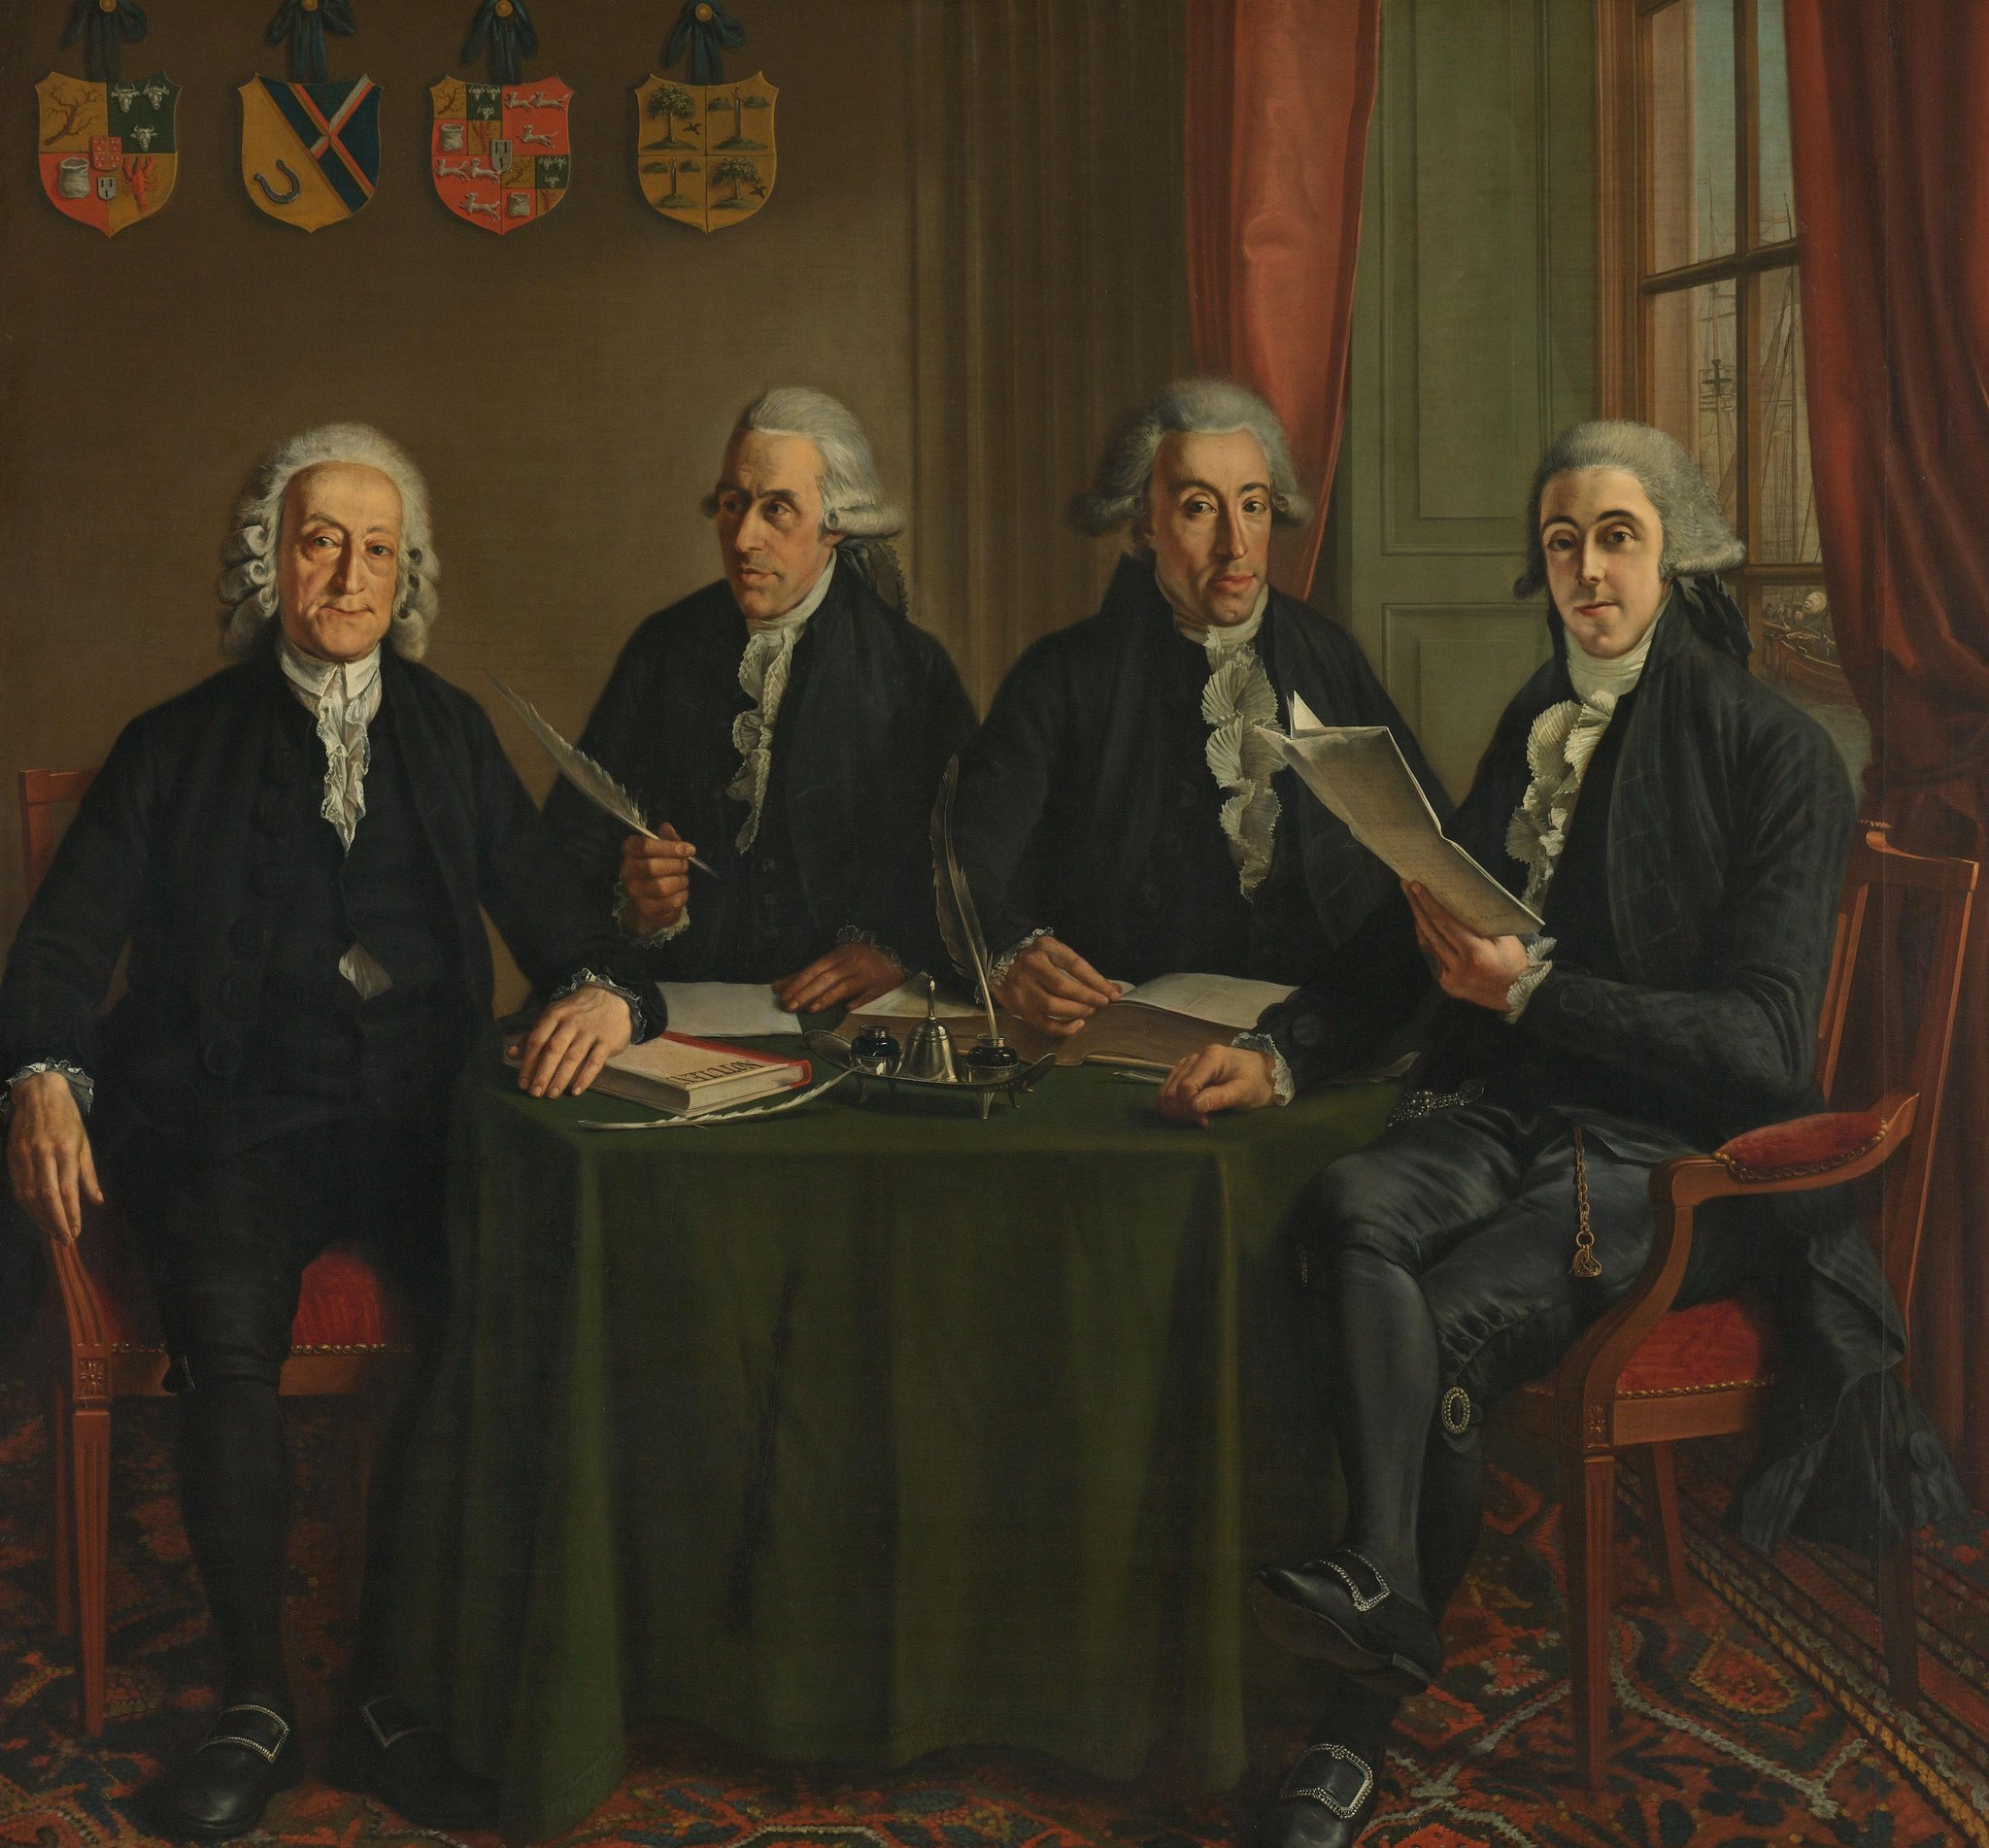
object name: painting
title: The Four Chief Commissioners of the Amsterdam Harbor Works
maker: wybrand hendriks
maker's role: draughtsman, painter, print maker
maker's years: 1744-1831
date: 1791-1795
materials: canvas, oil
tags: historical persons, board, esp. governors, trustees, etc. (dutch: 'regenten'), amsterdam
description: Wybrand Hendriks (1744 - 1831). The four chief commissioners of the Amsterdam harbour works, c. 1791 - 1795. On loan from the city of Amsterdam.